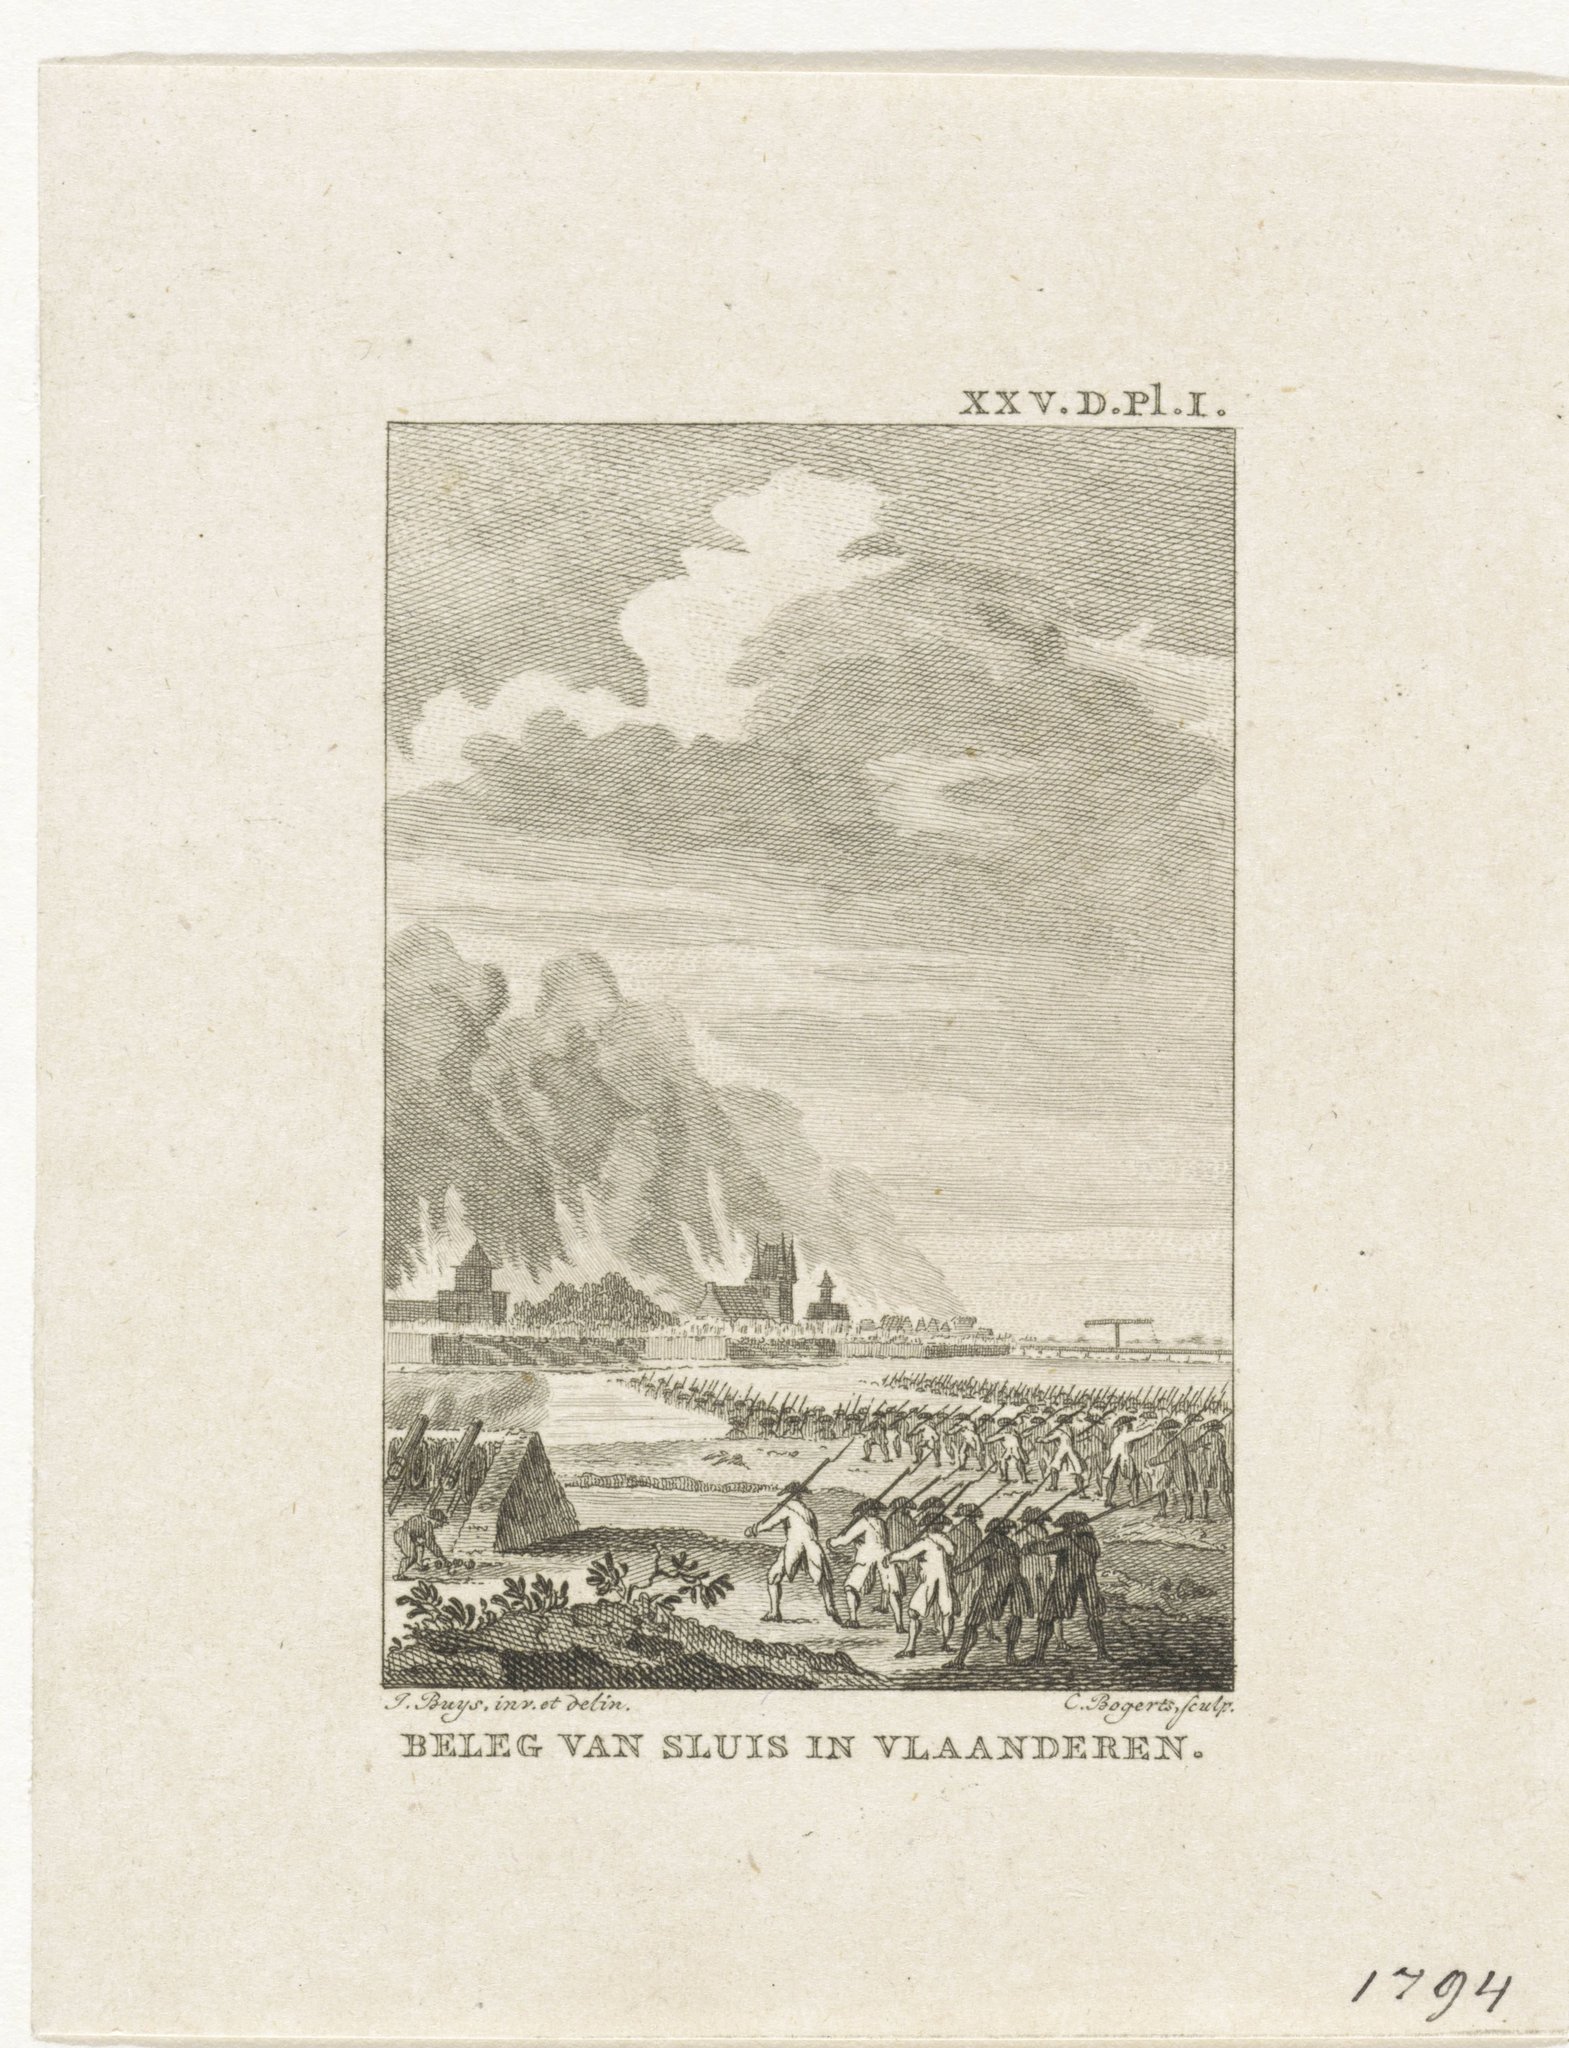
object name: print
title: Beleg van Sluis, 1794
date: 1794-1795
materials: paper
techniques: engraving, etching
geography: northern netherlands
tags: siege, position war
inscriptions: collector's mark: Lugt 2228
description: Gebruikt als illustratie in: J. Fokke, Geschiedenissen der Vereenigde Nederlanden voor de vaderlandsche jeugd, Johannes Allart, Amsterdam 1783-1795, 25 delen, dl. 25, pl. 1.